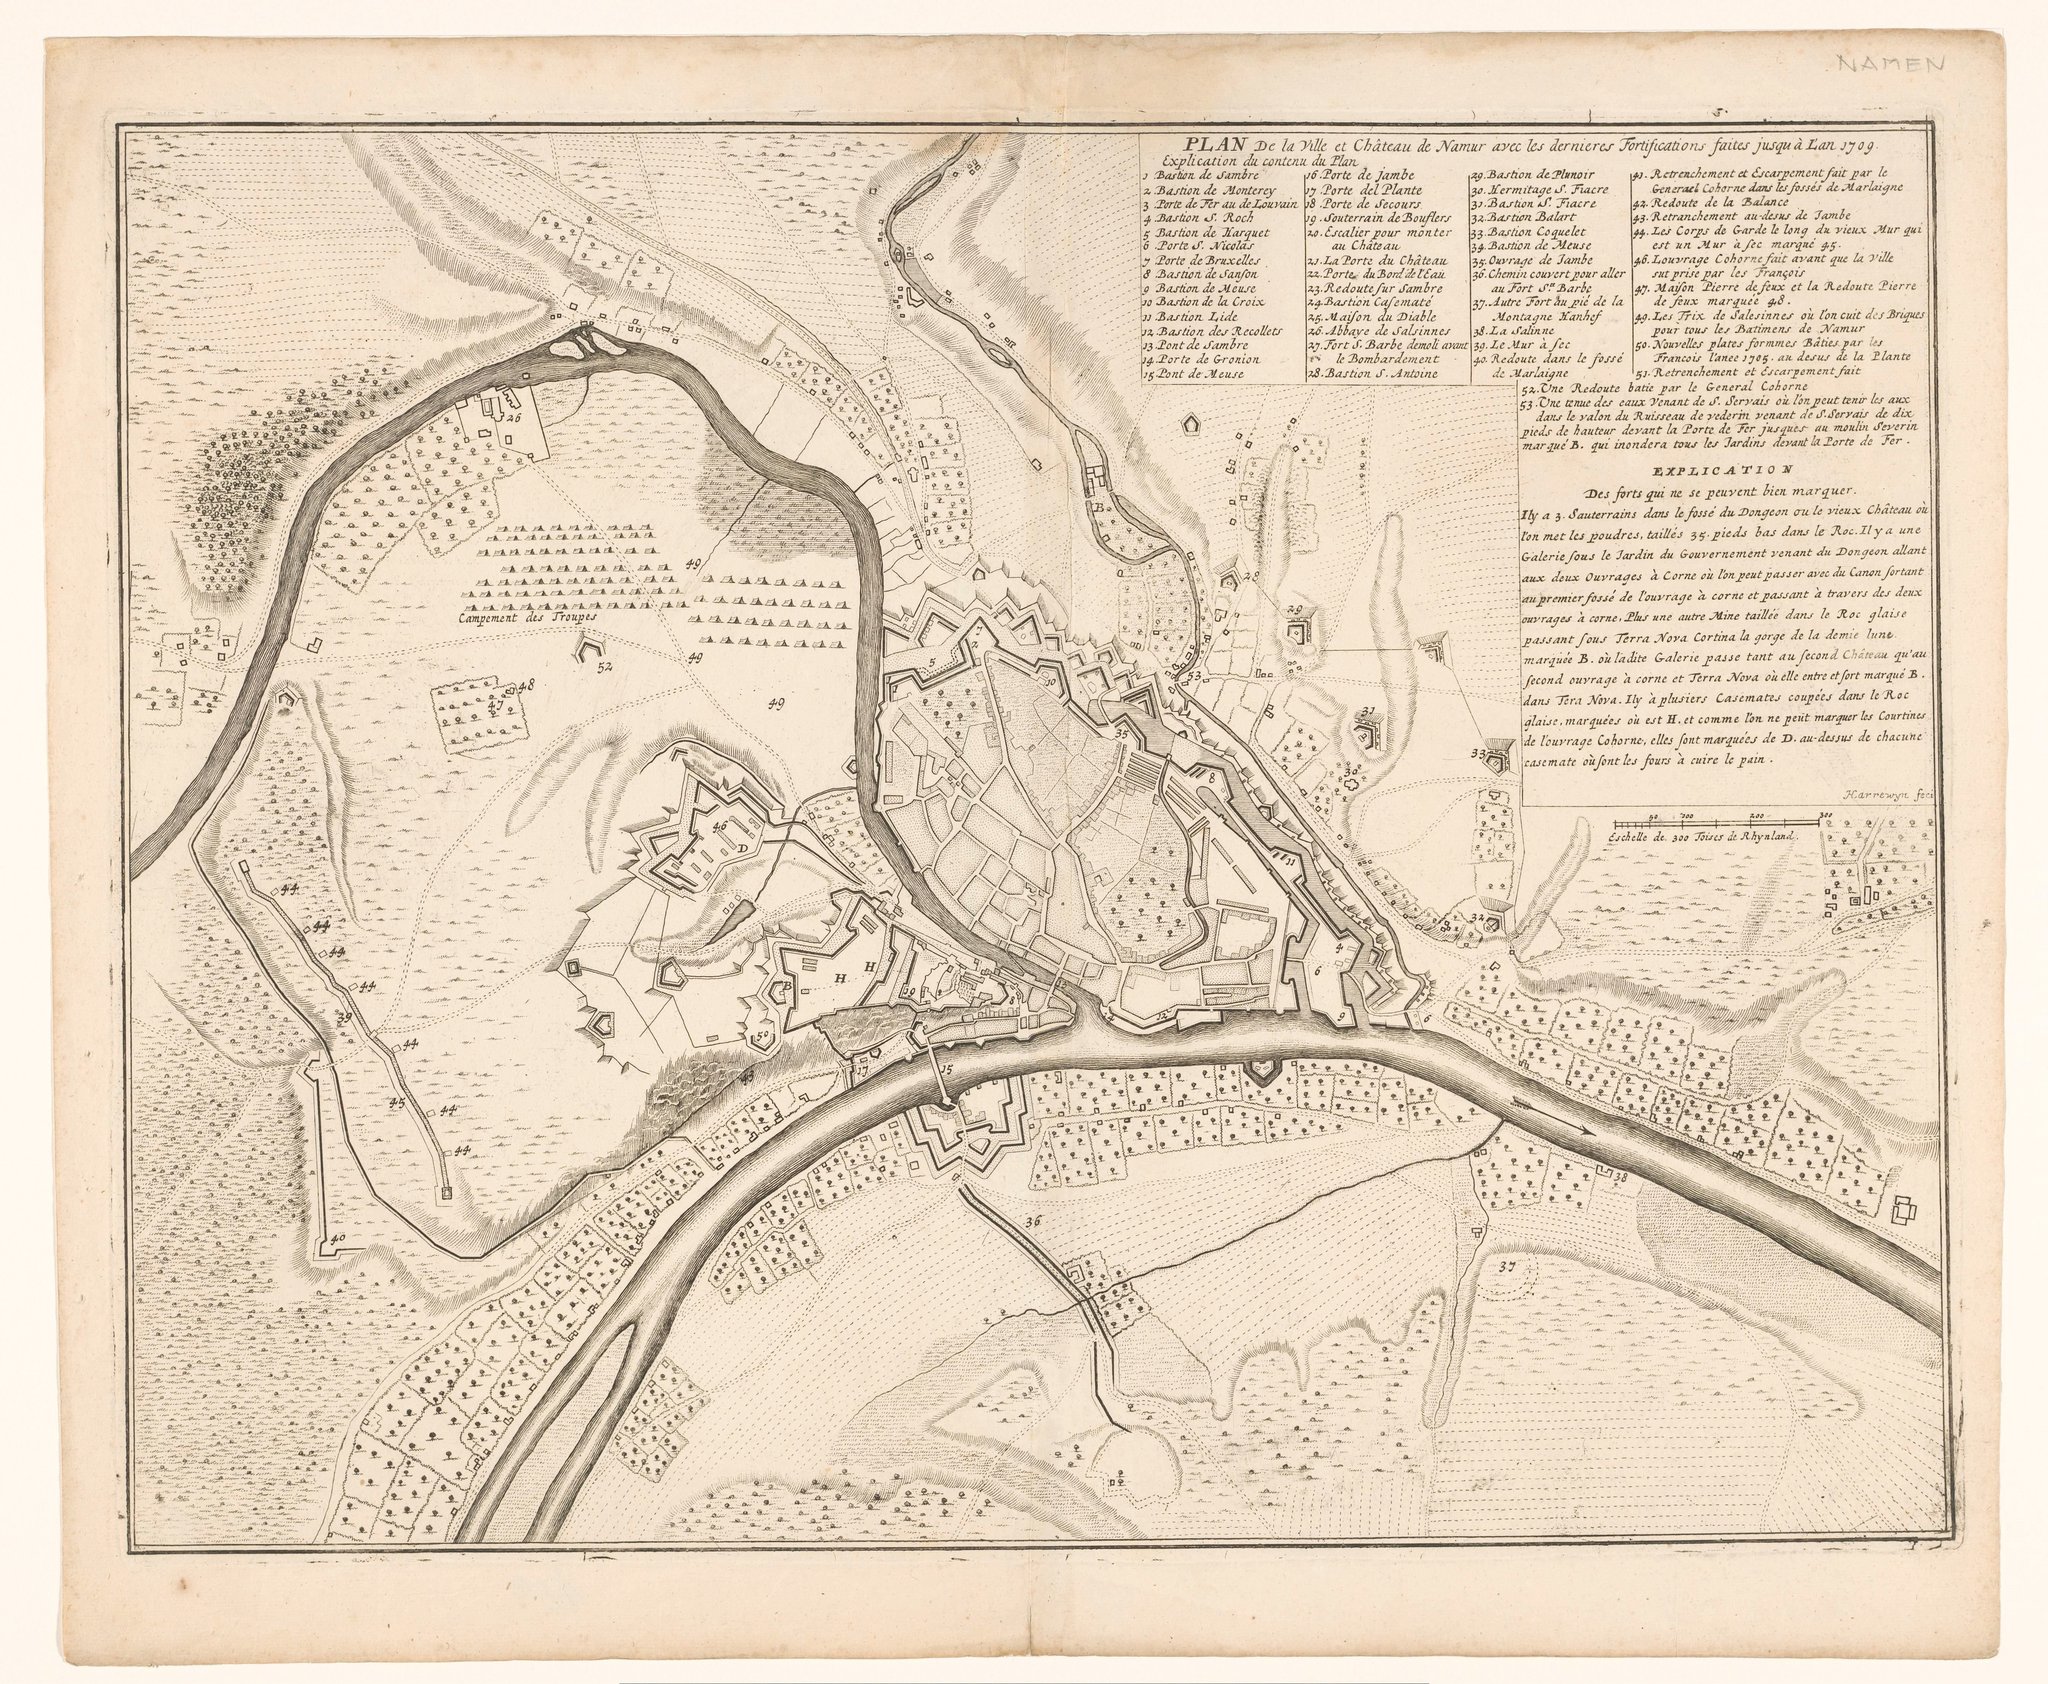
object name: print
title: Plattegrond van Namen, 1709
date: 1709-1712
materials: paper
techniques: etching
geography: brussels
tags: maps of cities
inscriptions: collector's mark: Lugt 2228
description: Prent ook gebruikt in: Table des cartes des Pays-Bas et des frontieres de France, avec un recueil des plans des villes, sieges et battailles données entre les hauts allies et la France. Brussel: Eugene Henry Fricx, 1712. Bovenstaande publicatie kent meerdere drukken waarbij datum onveranderd is gebleven.